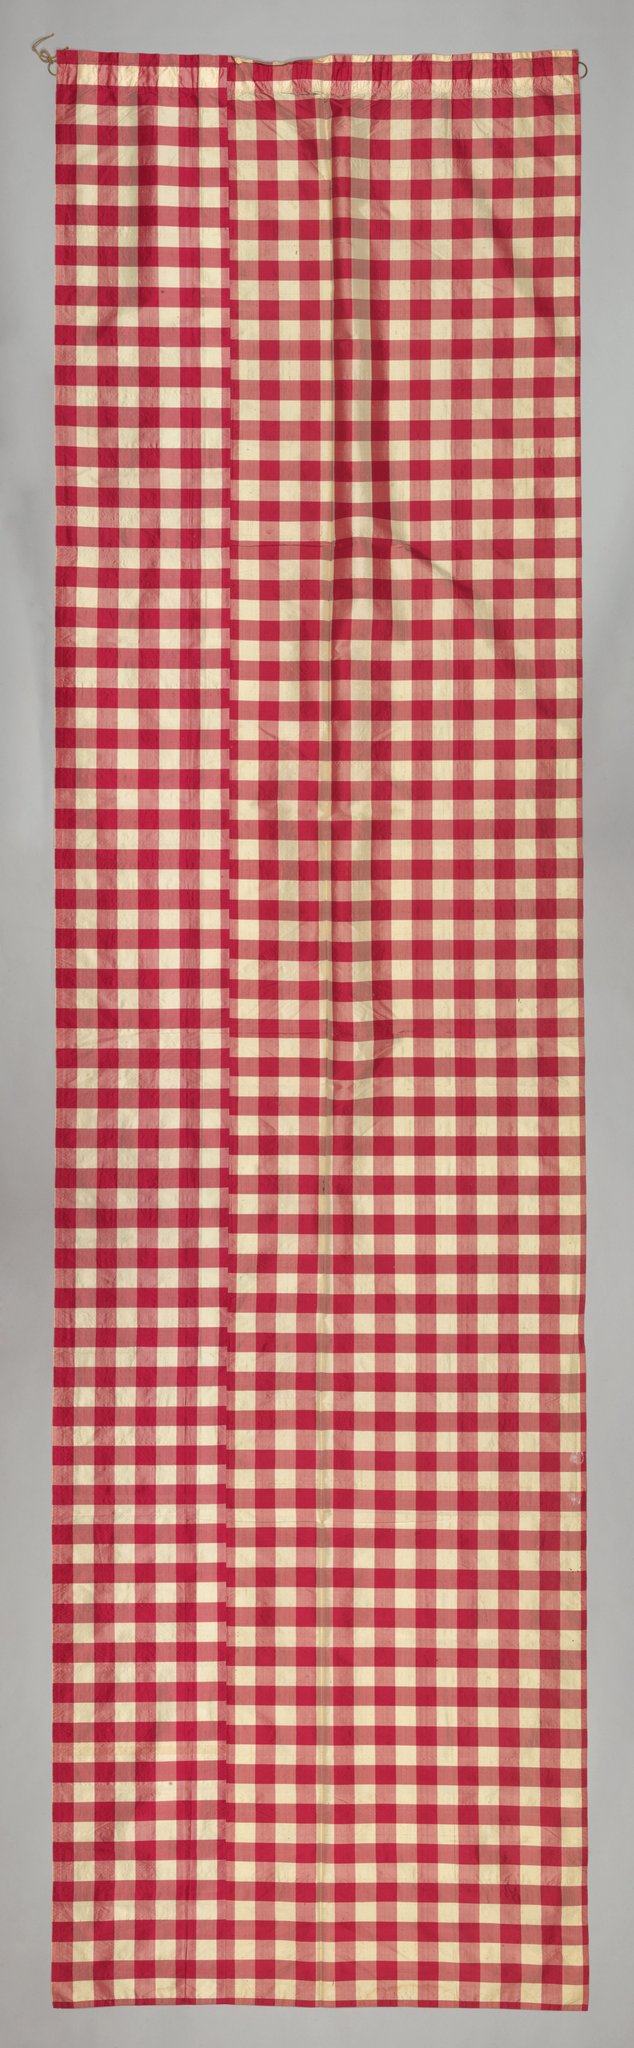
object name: curtain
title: Rood-wit geblokt gordijn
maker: Anonymous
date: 1776-1800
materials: linen, silk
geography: northern netherlands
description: Gordijn van rood-wit geblokte zijde met een rechte bovenzijde. Aan de achterzijde bovenaan een grof linnen rand met koperen ringen. Aan een gordijnring aan het uiteinde is een touwtje bevestigd.